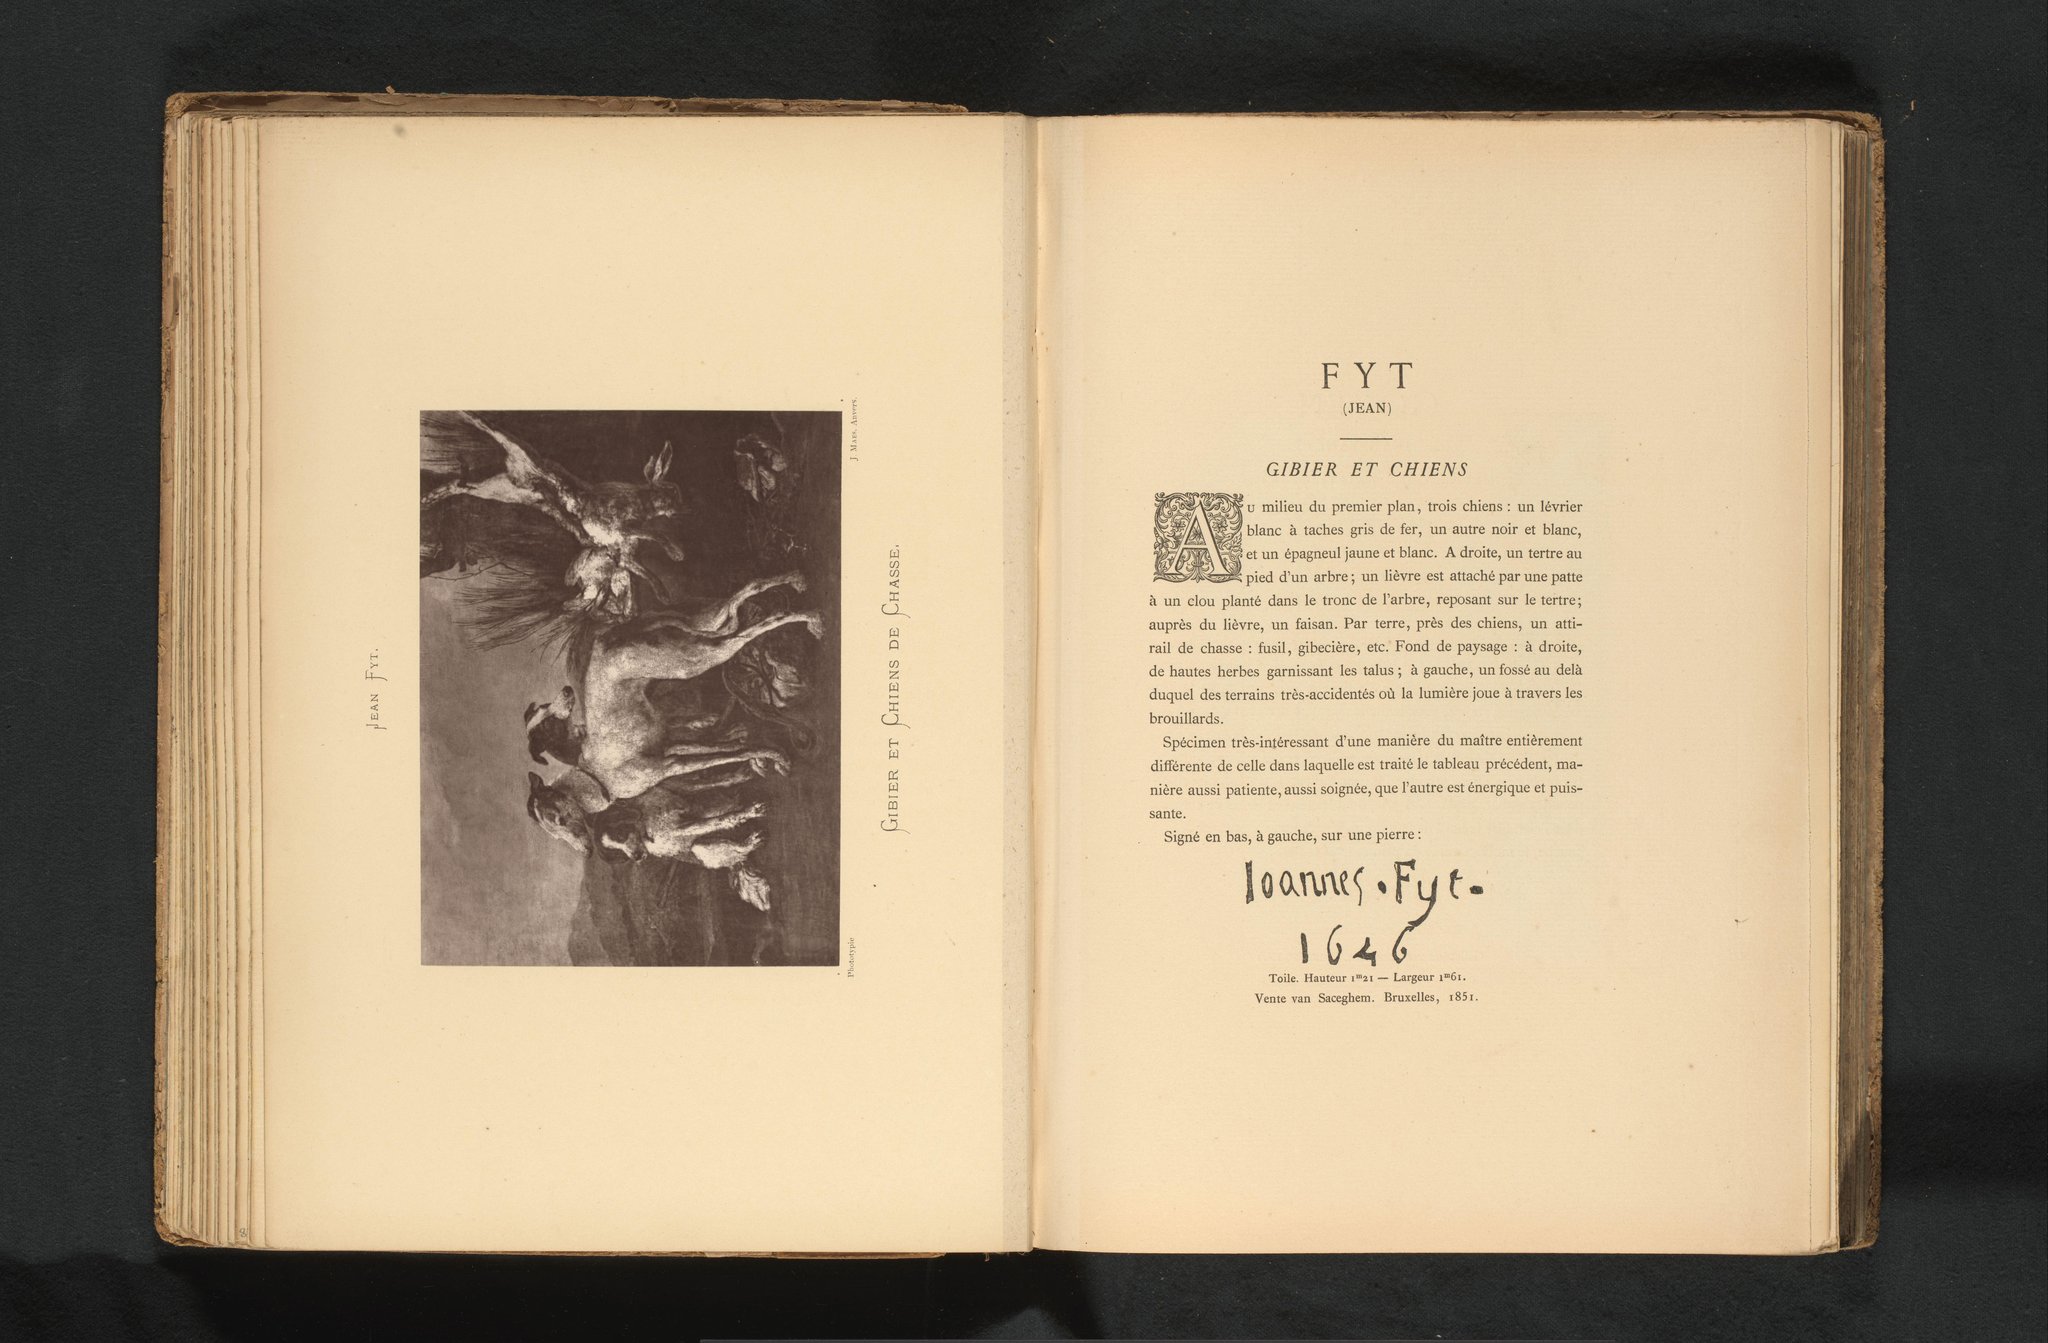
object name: photomechanical print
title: Gibier et Chiens de Chasse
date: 1873-1878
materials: paper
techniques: woodburytype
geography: antwerp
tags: hunting dogs, rodents: hare